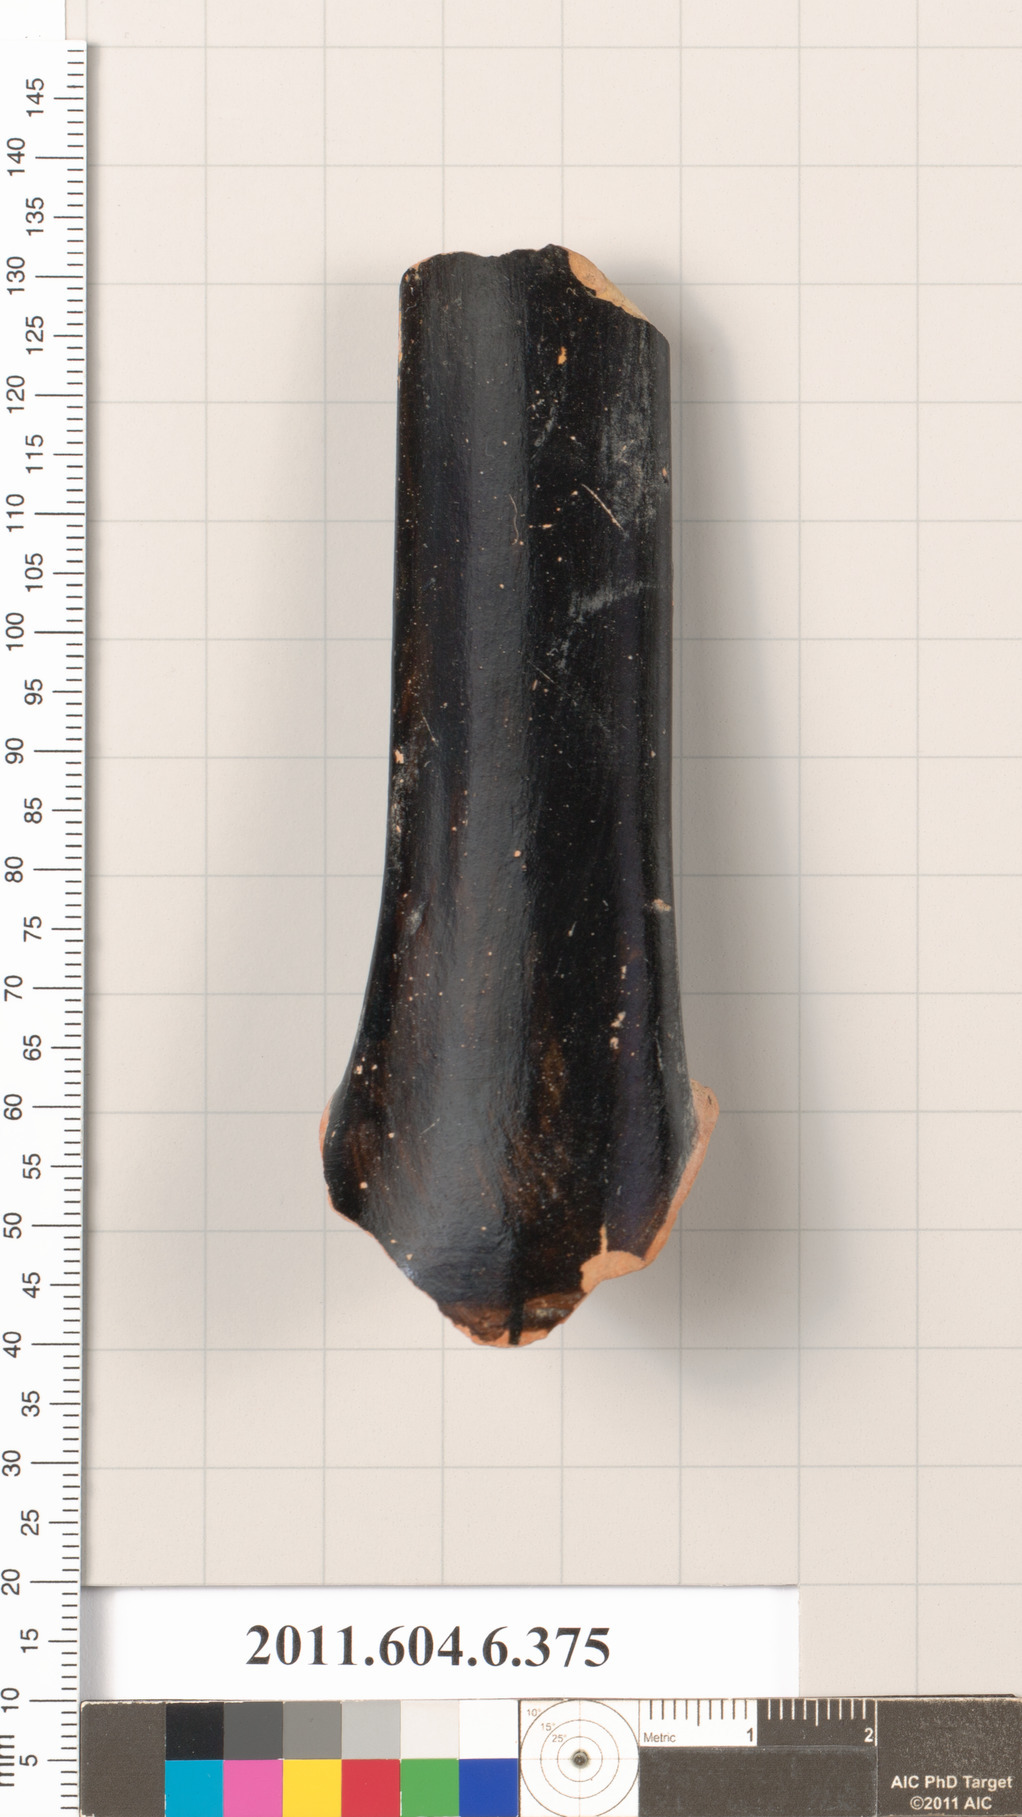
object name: pelike fragment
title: Terracotta fragment of a pelike (jar)?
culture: greek, attic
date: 600-401 BCE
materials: terracotta